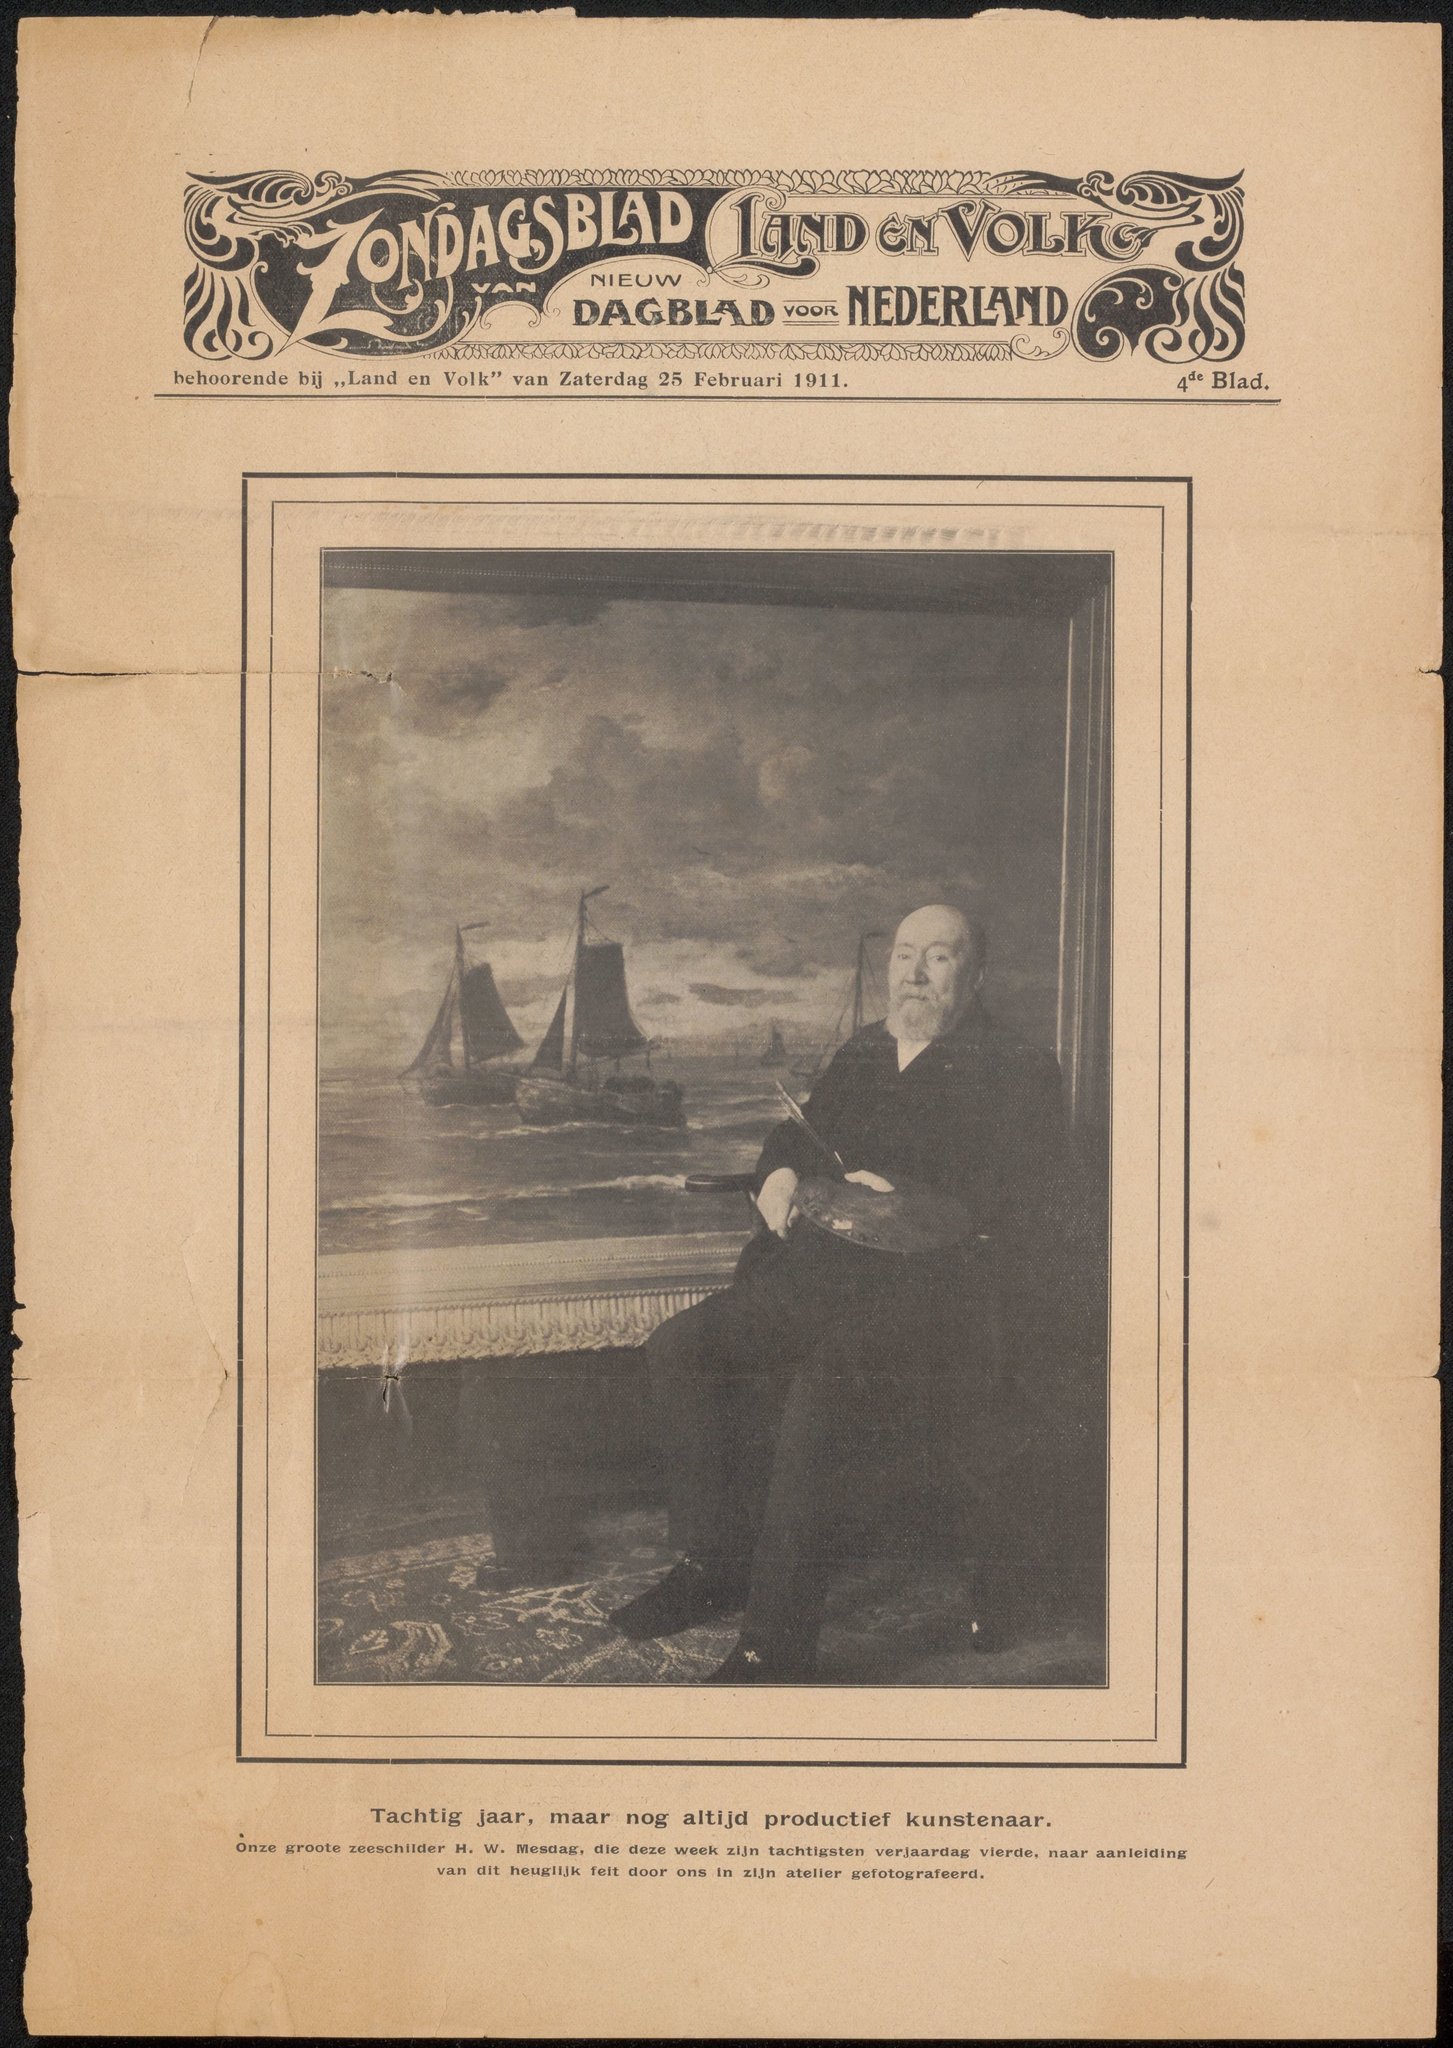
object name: newspaper clipping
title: Krantenknipsel uit archief Philip Zilcken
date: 1911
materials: paper, ink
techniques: printing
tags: the hague, painter, print maker, draughtsman, hendrik willem mesdag, philip zilcken